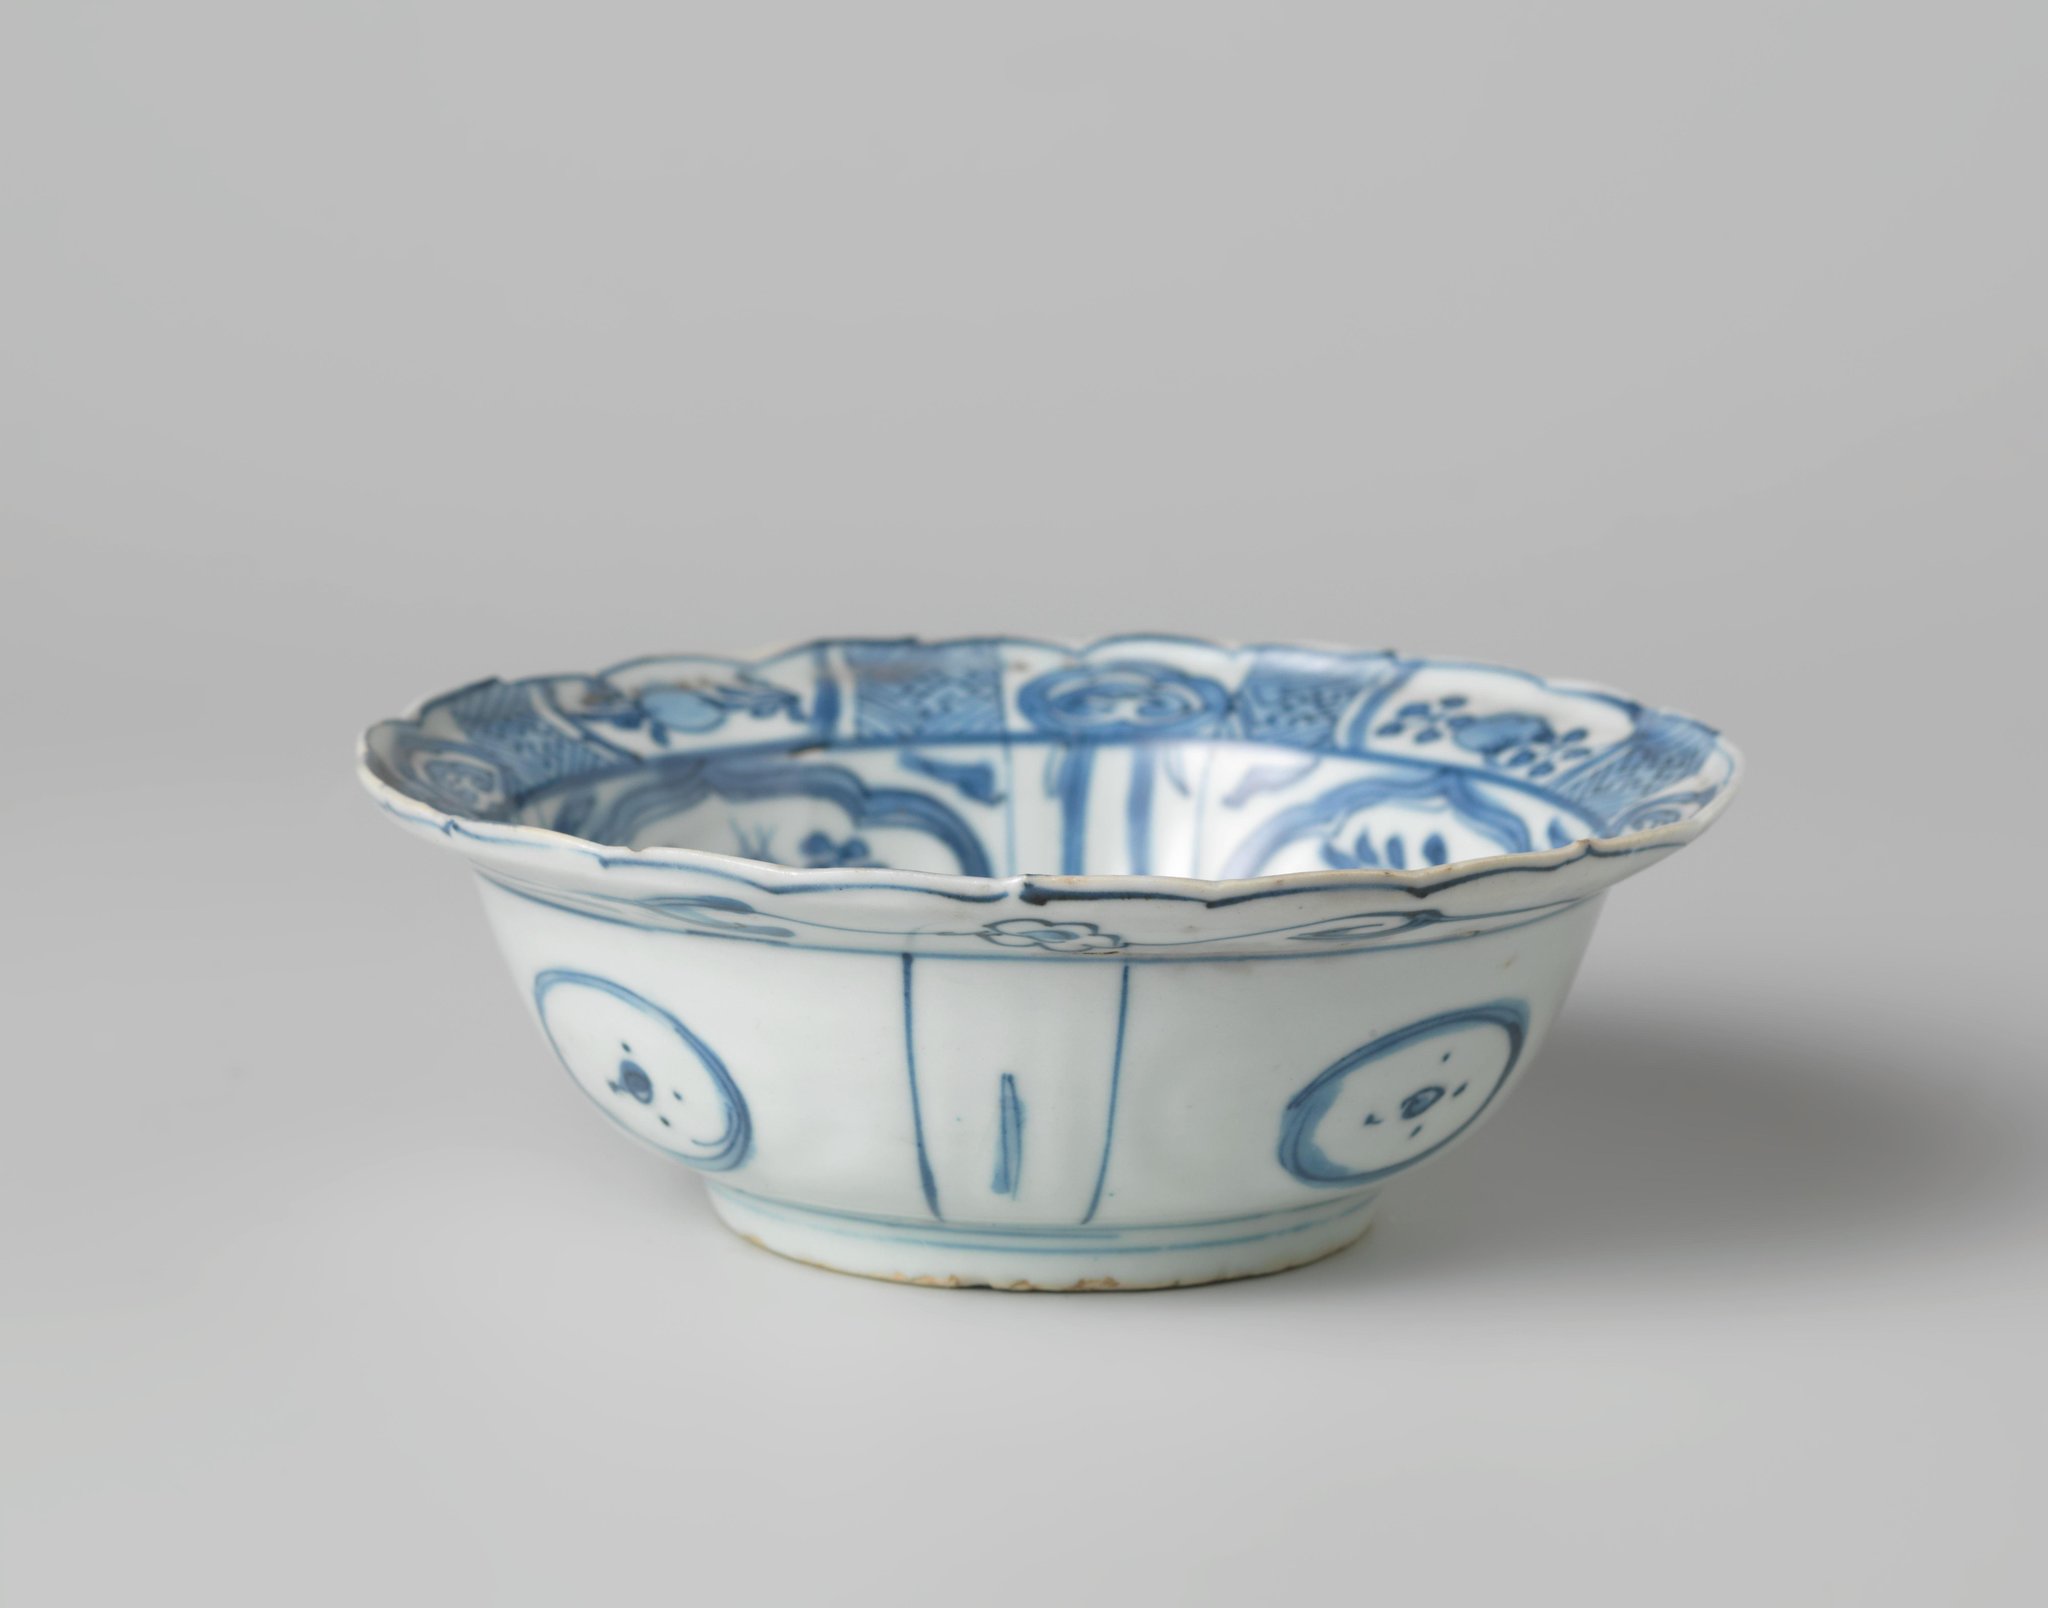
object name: bowl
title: Klapmuts bowl with a rock, chrysanthemums and a butterfly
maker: Anonymous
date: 1600-1649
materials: cobalt, glaze, paint, porcelain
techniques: firing, turning, vitrification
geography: china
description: Klapmutskom gedecoreerd in onderglazuur blauw. De decoratie is ingedeeld in velden met bloeiende planten, geluksymbolen en geometrische patronen. In het plat een bloeiende chrysant bij een rots en een vlinder.